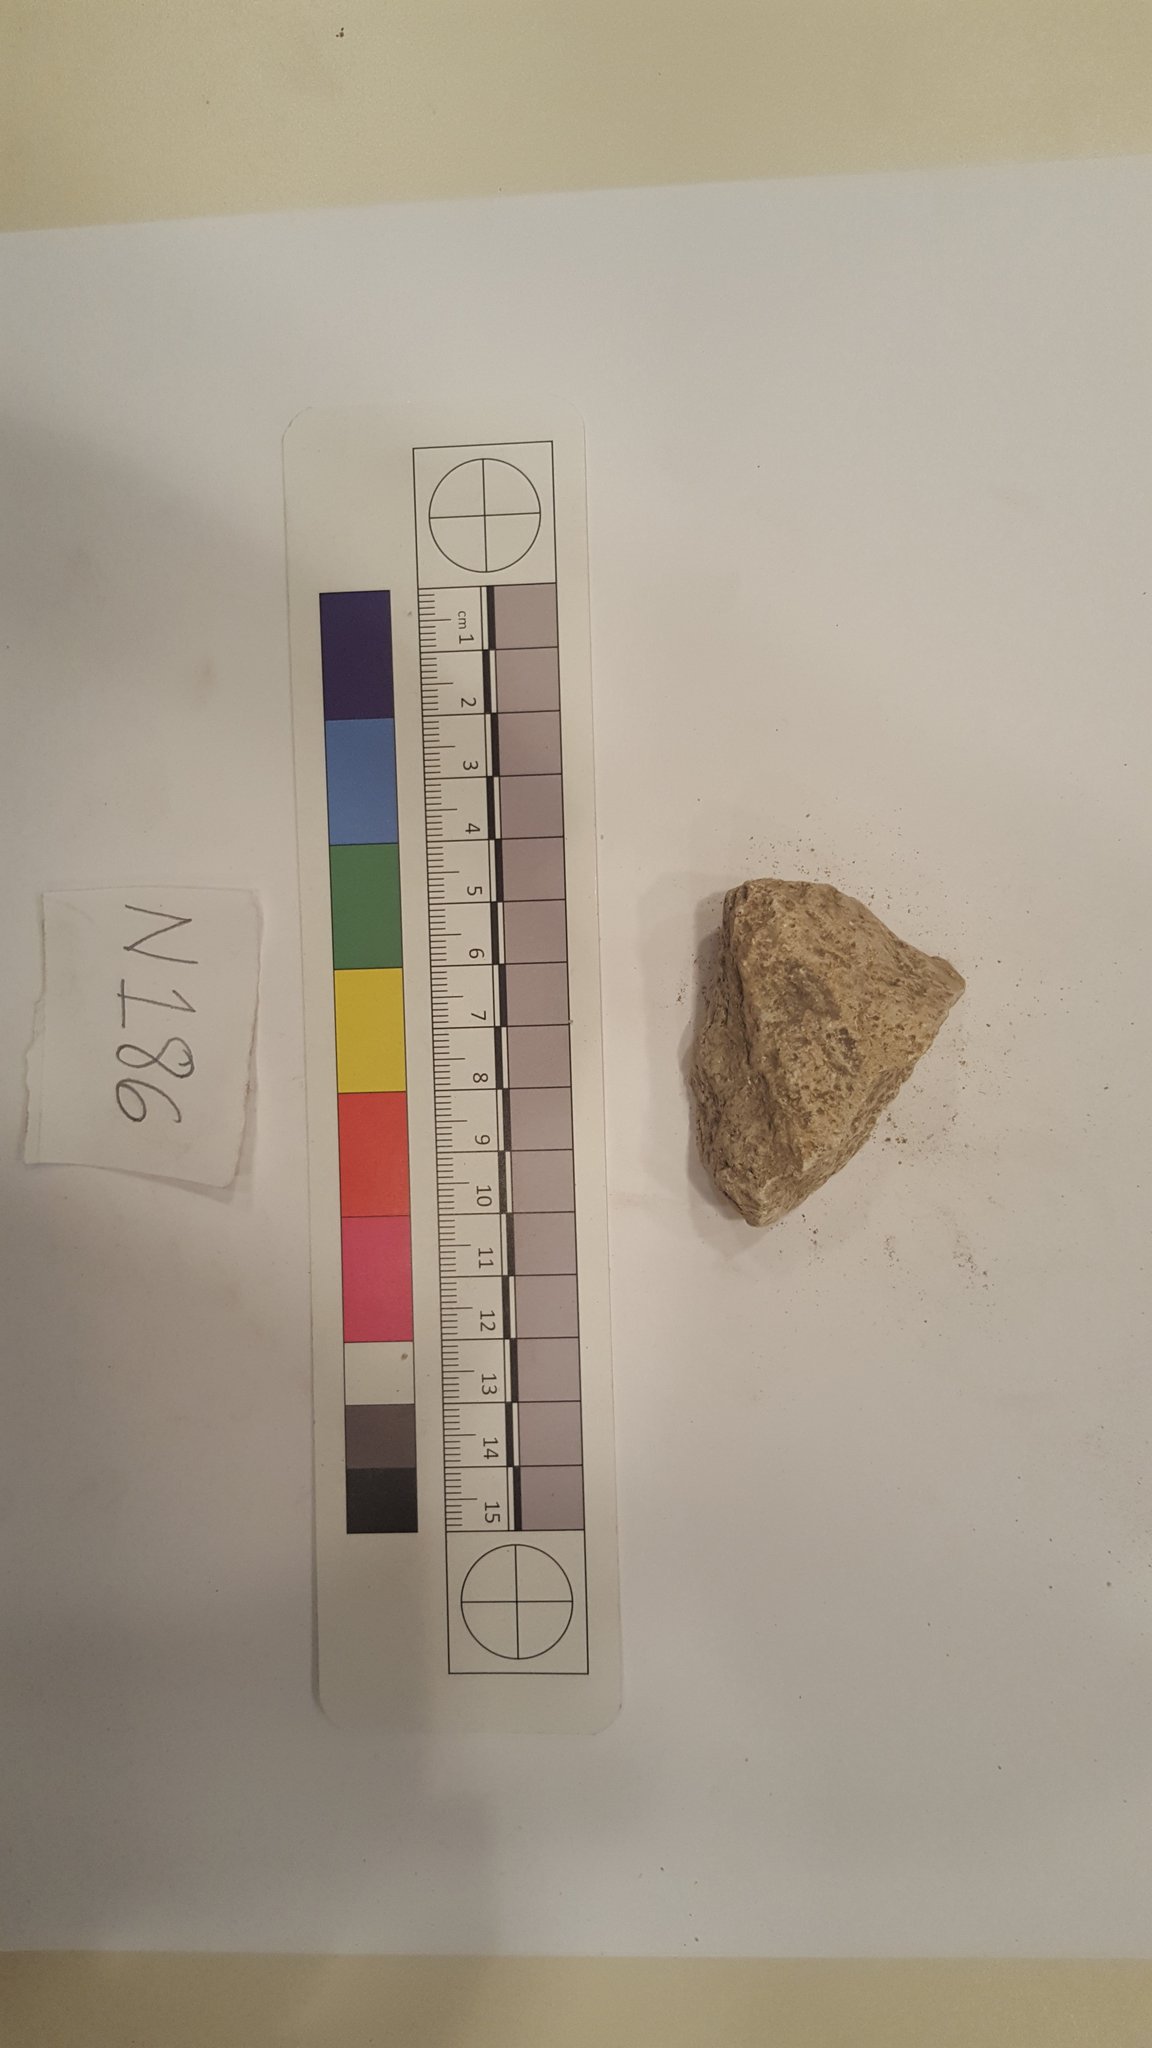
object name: fragment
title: Stucco Fragment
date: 701-1200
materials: plaster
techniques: carving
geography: iran